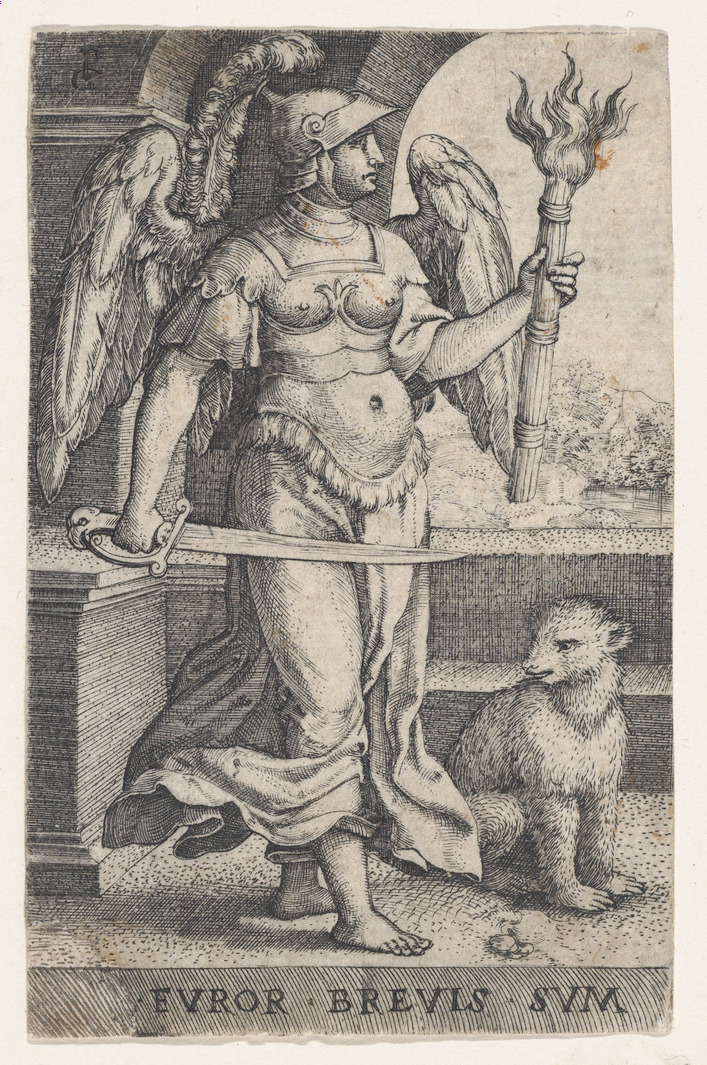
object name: print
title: Wrath (Ira), from "The Seven Vices"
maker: georg pencz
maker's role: artist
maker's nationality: german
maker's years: 1500-1550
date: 1536-1546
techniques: engraving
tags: bears,swords,allegory